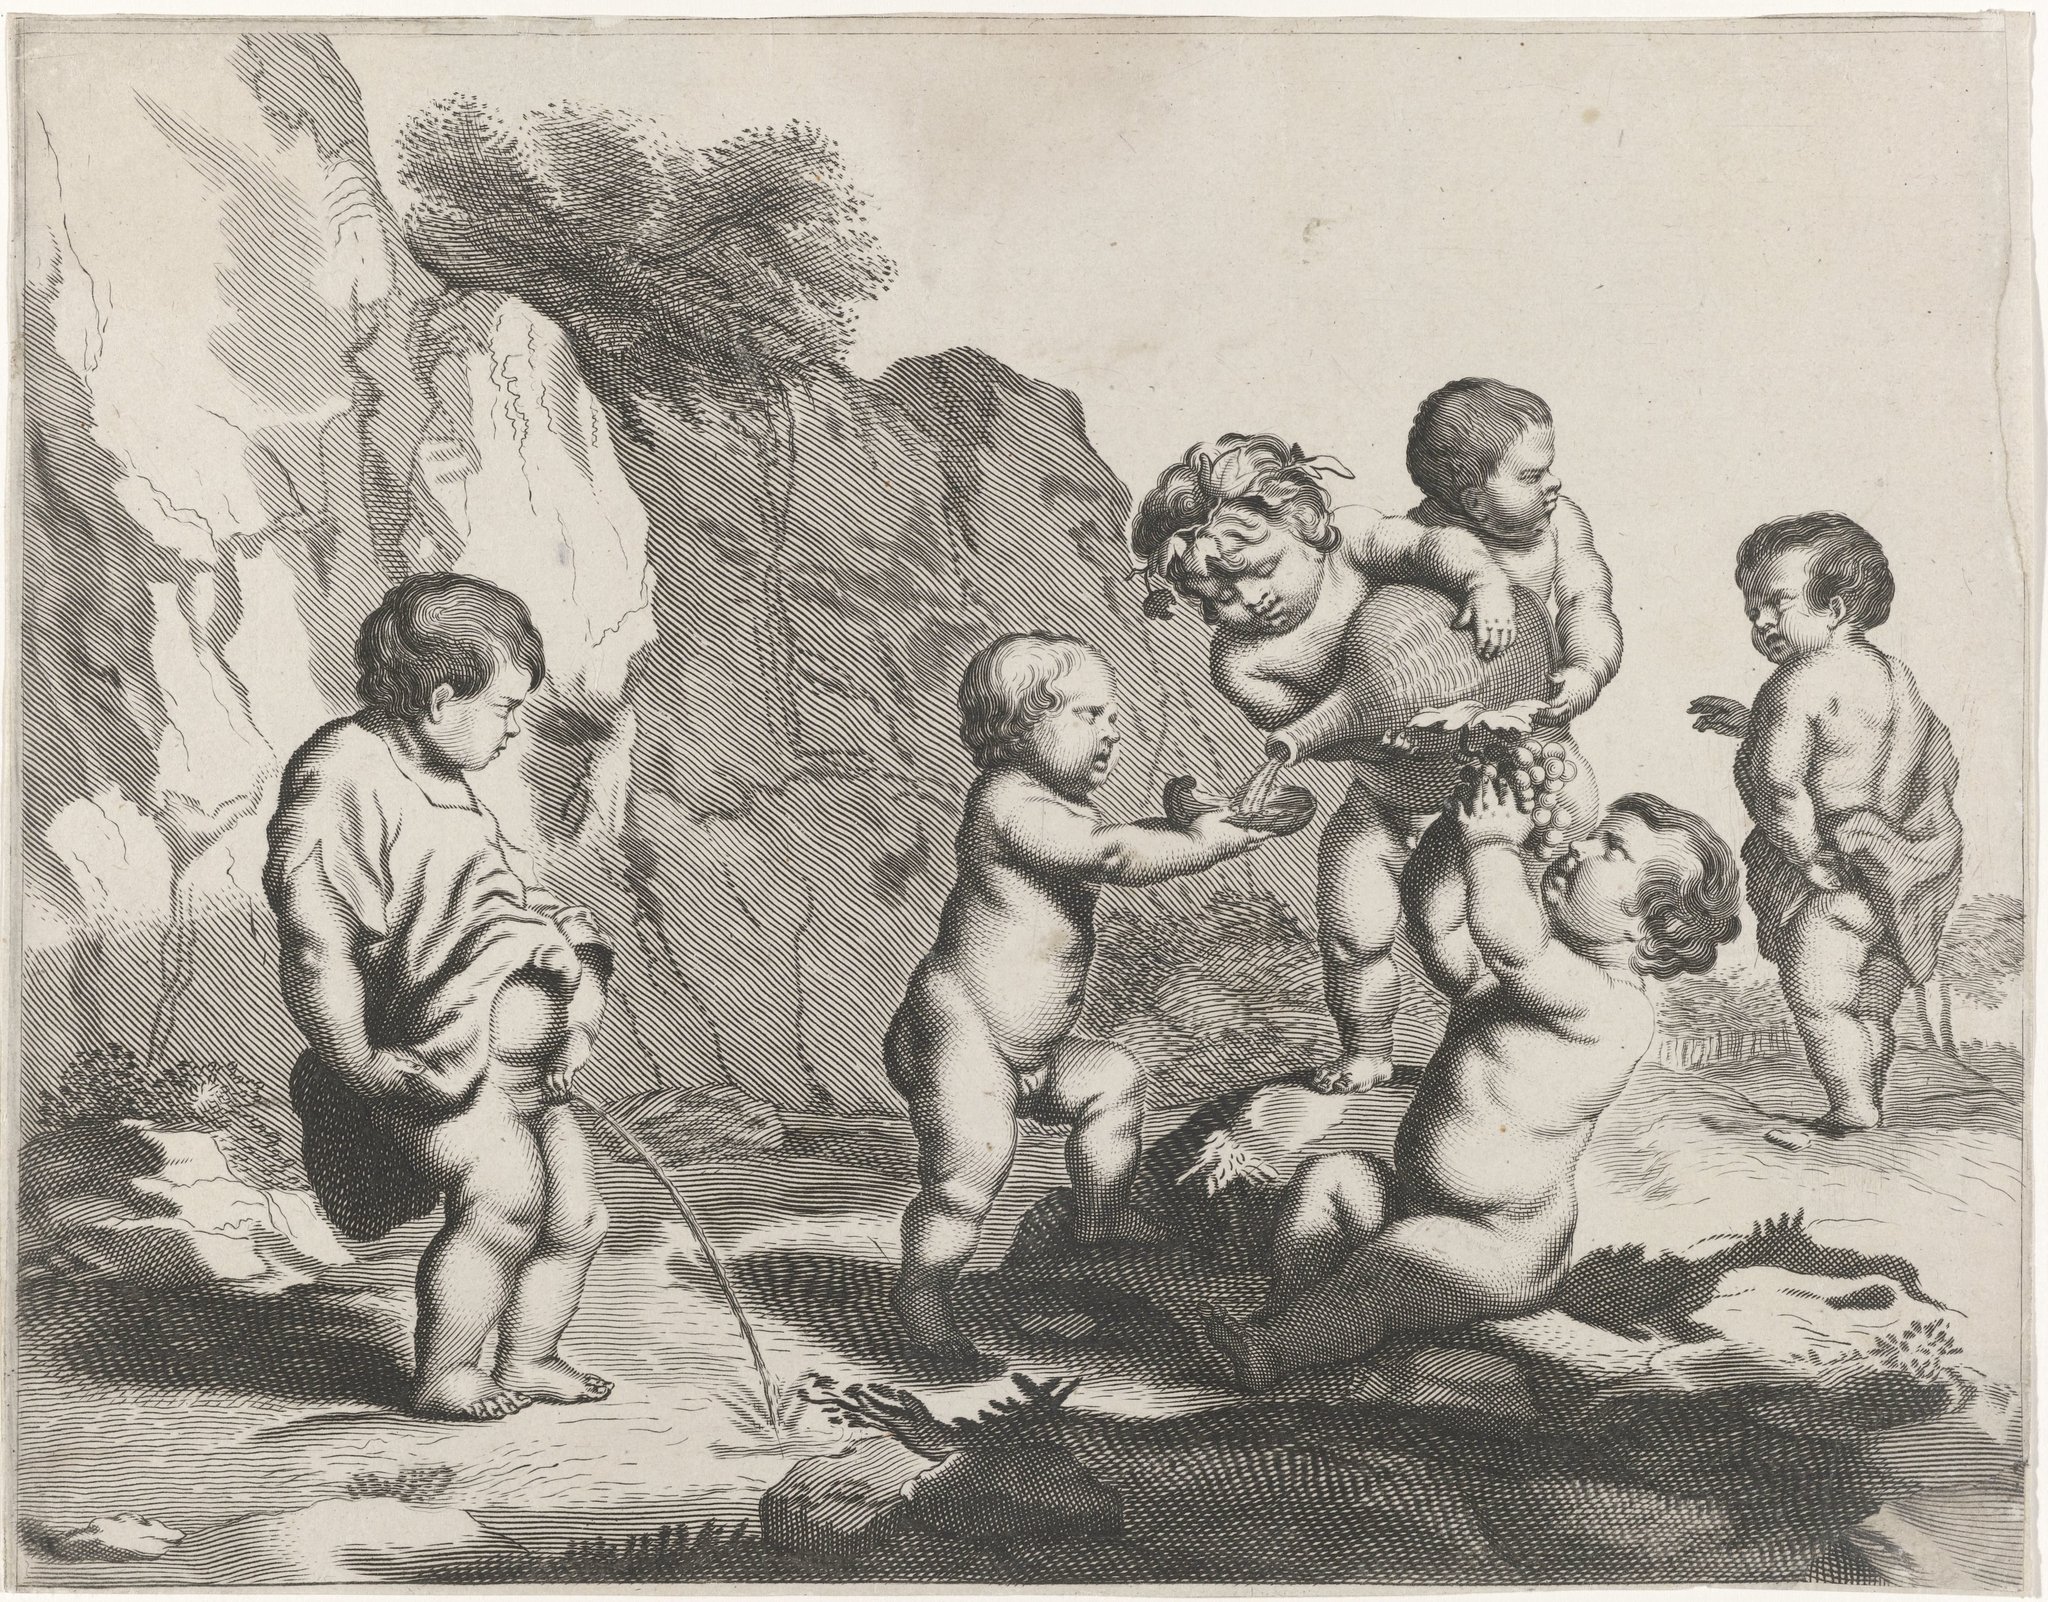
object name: print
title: Spelende putti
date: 1640-1655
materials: paper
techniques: engraving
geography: amsterdam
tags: jar, jug (used as drinking-vessel), urination, cupids: 'amores', 'amoretti', 'putti', bunch of grapes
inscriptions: collector's mark: Lugt 240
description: Links een plassende putto. Rechts schenkt een putto drinken uit een karaf in een opgehouden schelp. Een andere putto eet van een druiventros.